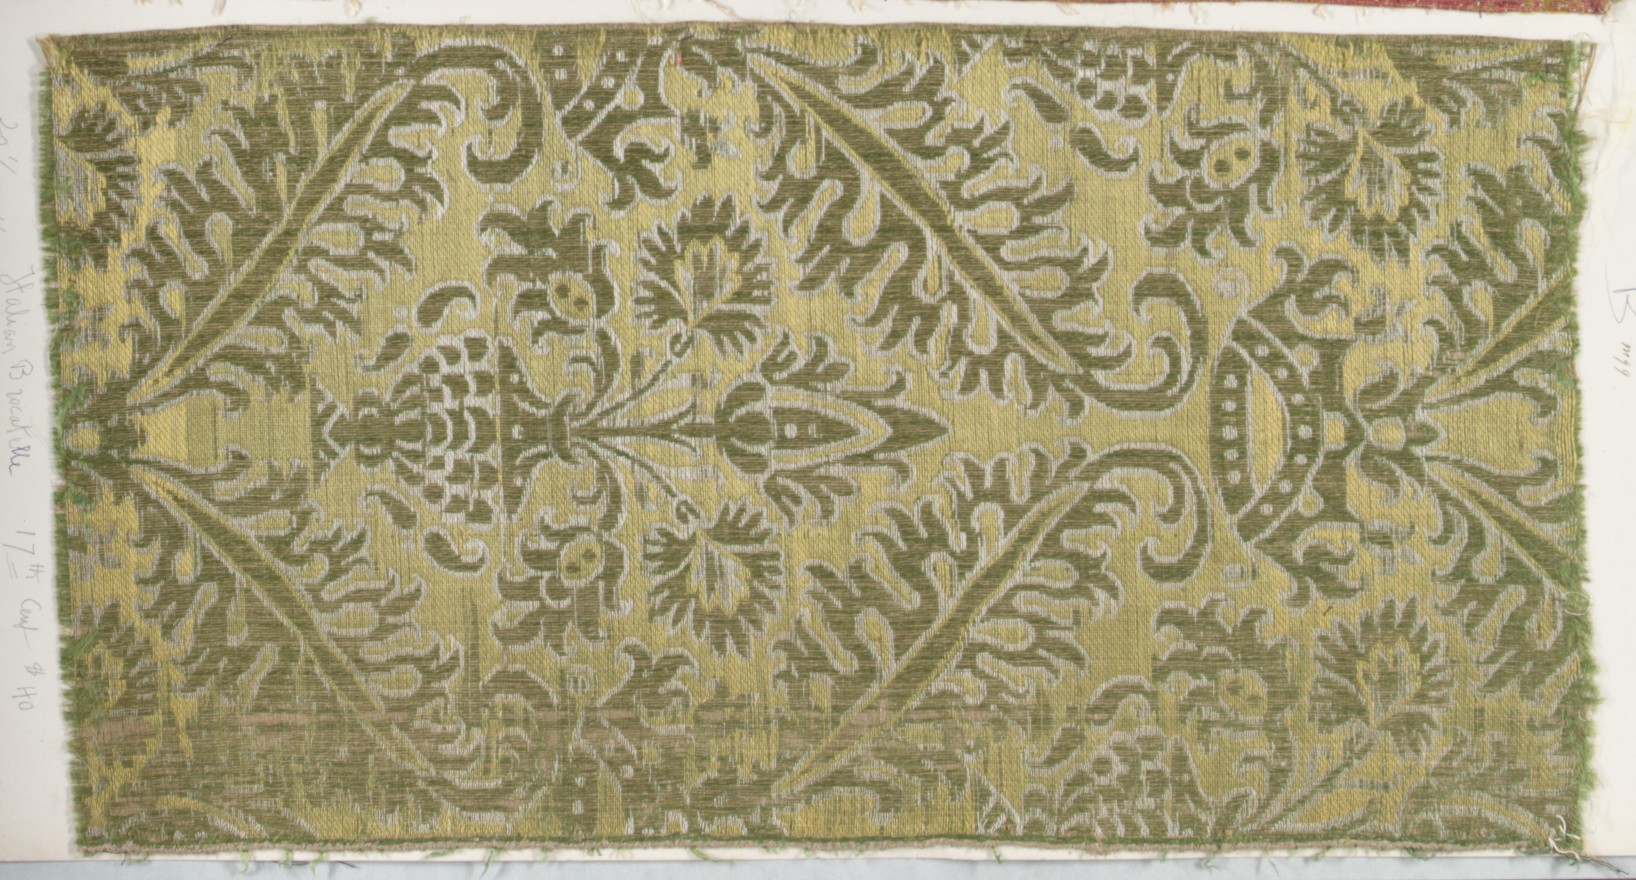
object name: fragment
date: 1601-1700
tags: leaves